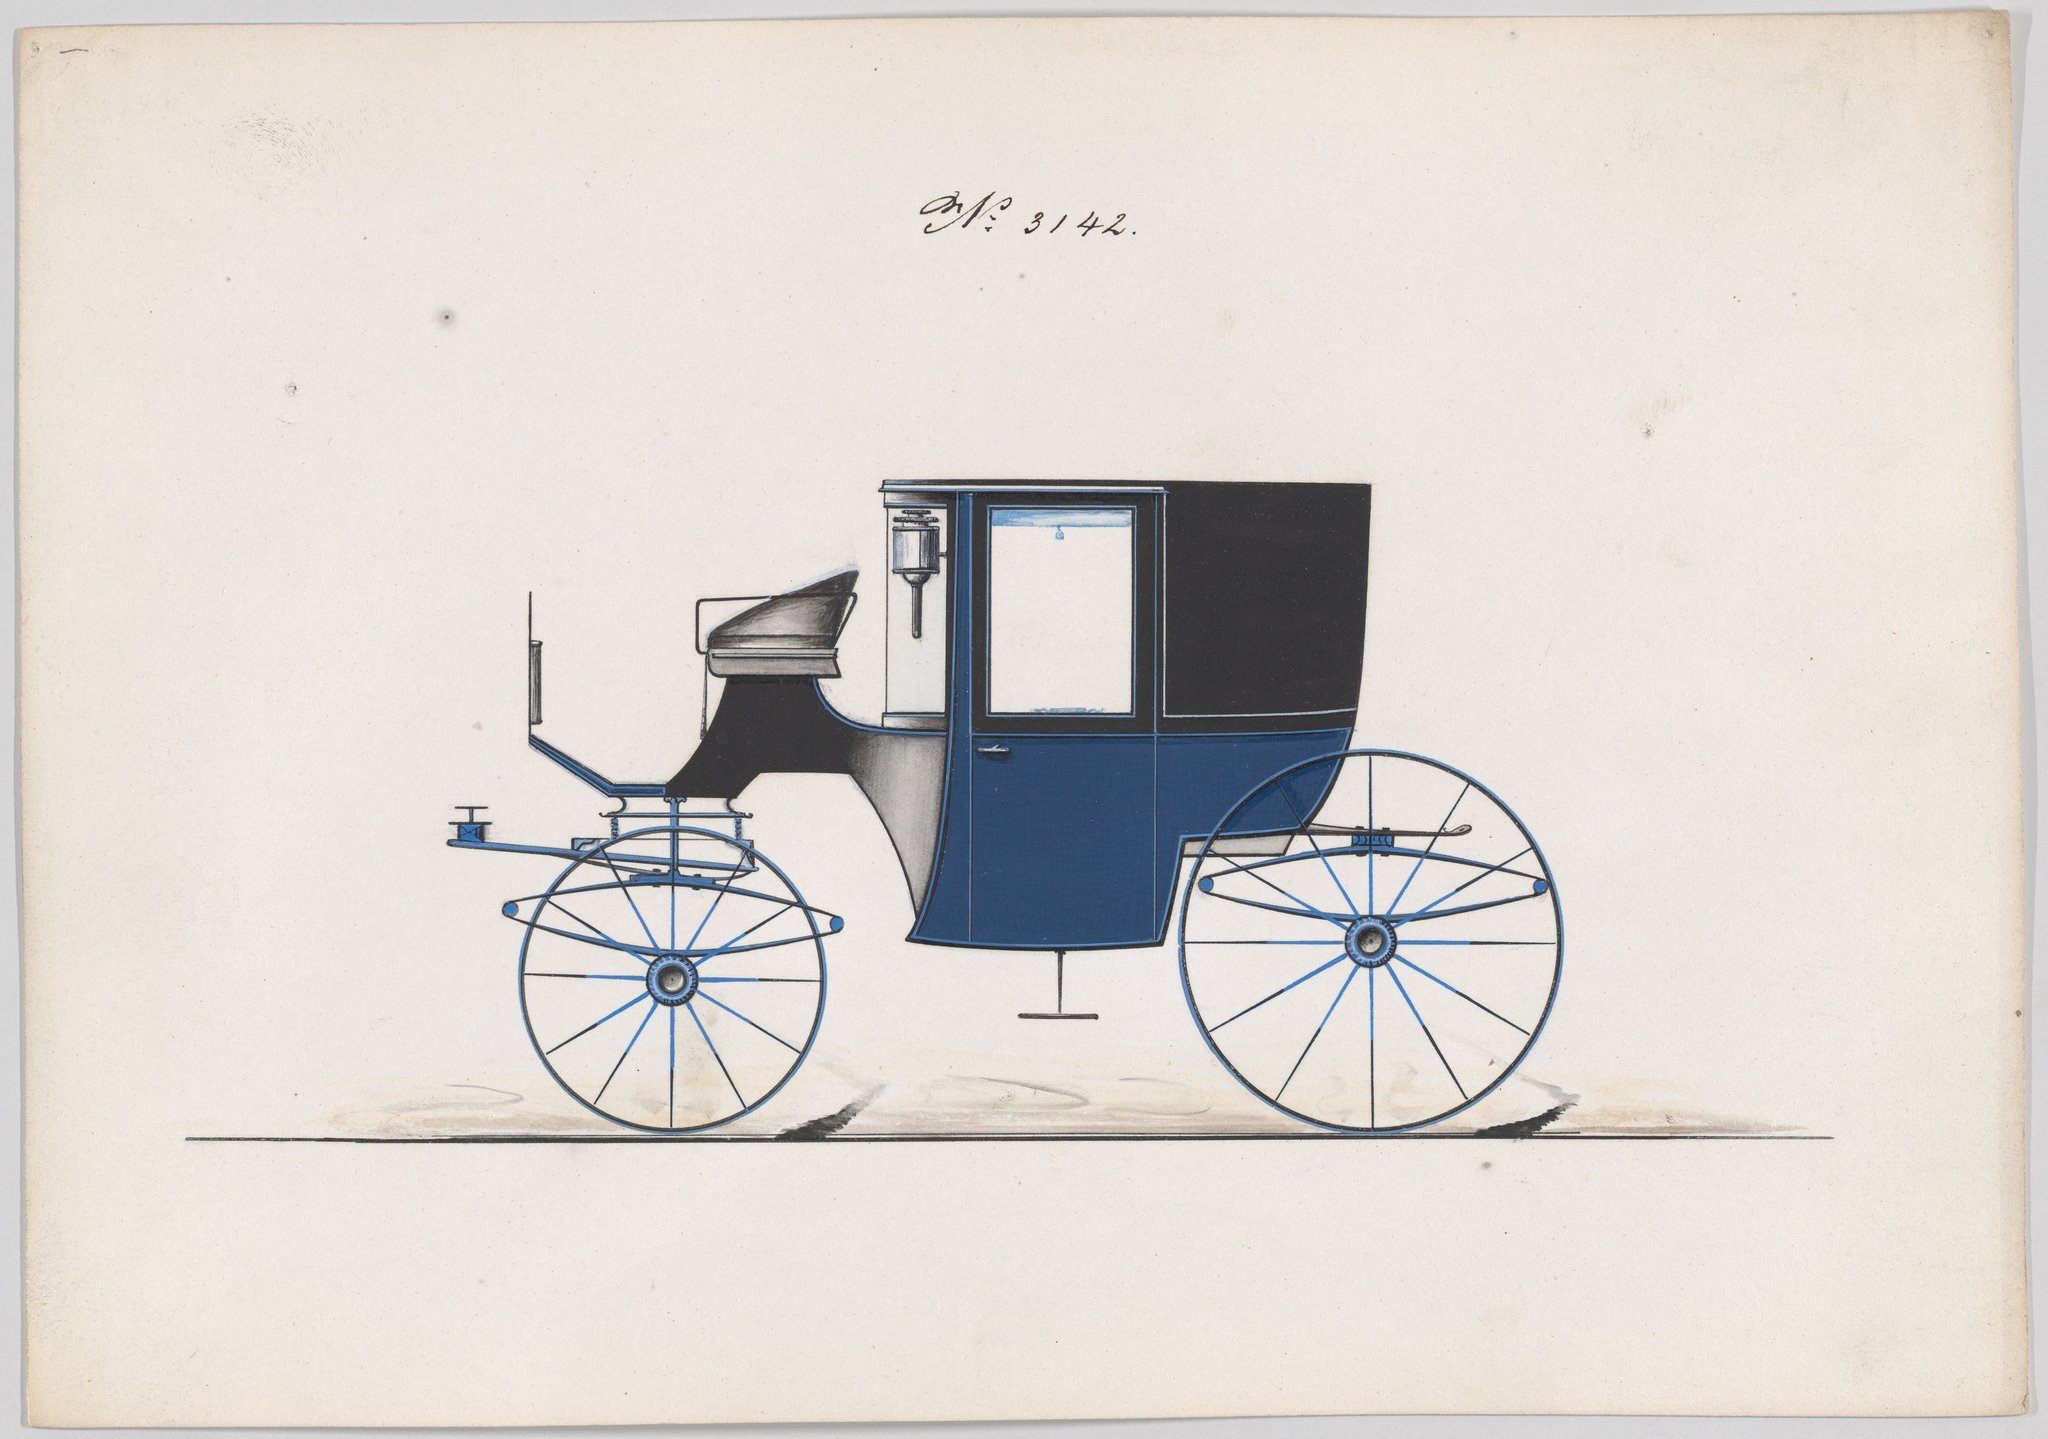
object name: drawing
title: Design for Coupé, no. 3142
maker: brewster & co.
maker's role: manufacturer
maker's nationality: american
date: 1875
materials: gouache, ink, watercolor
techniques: pen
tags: carriages